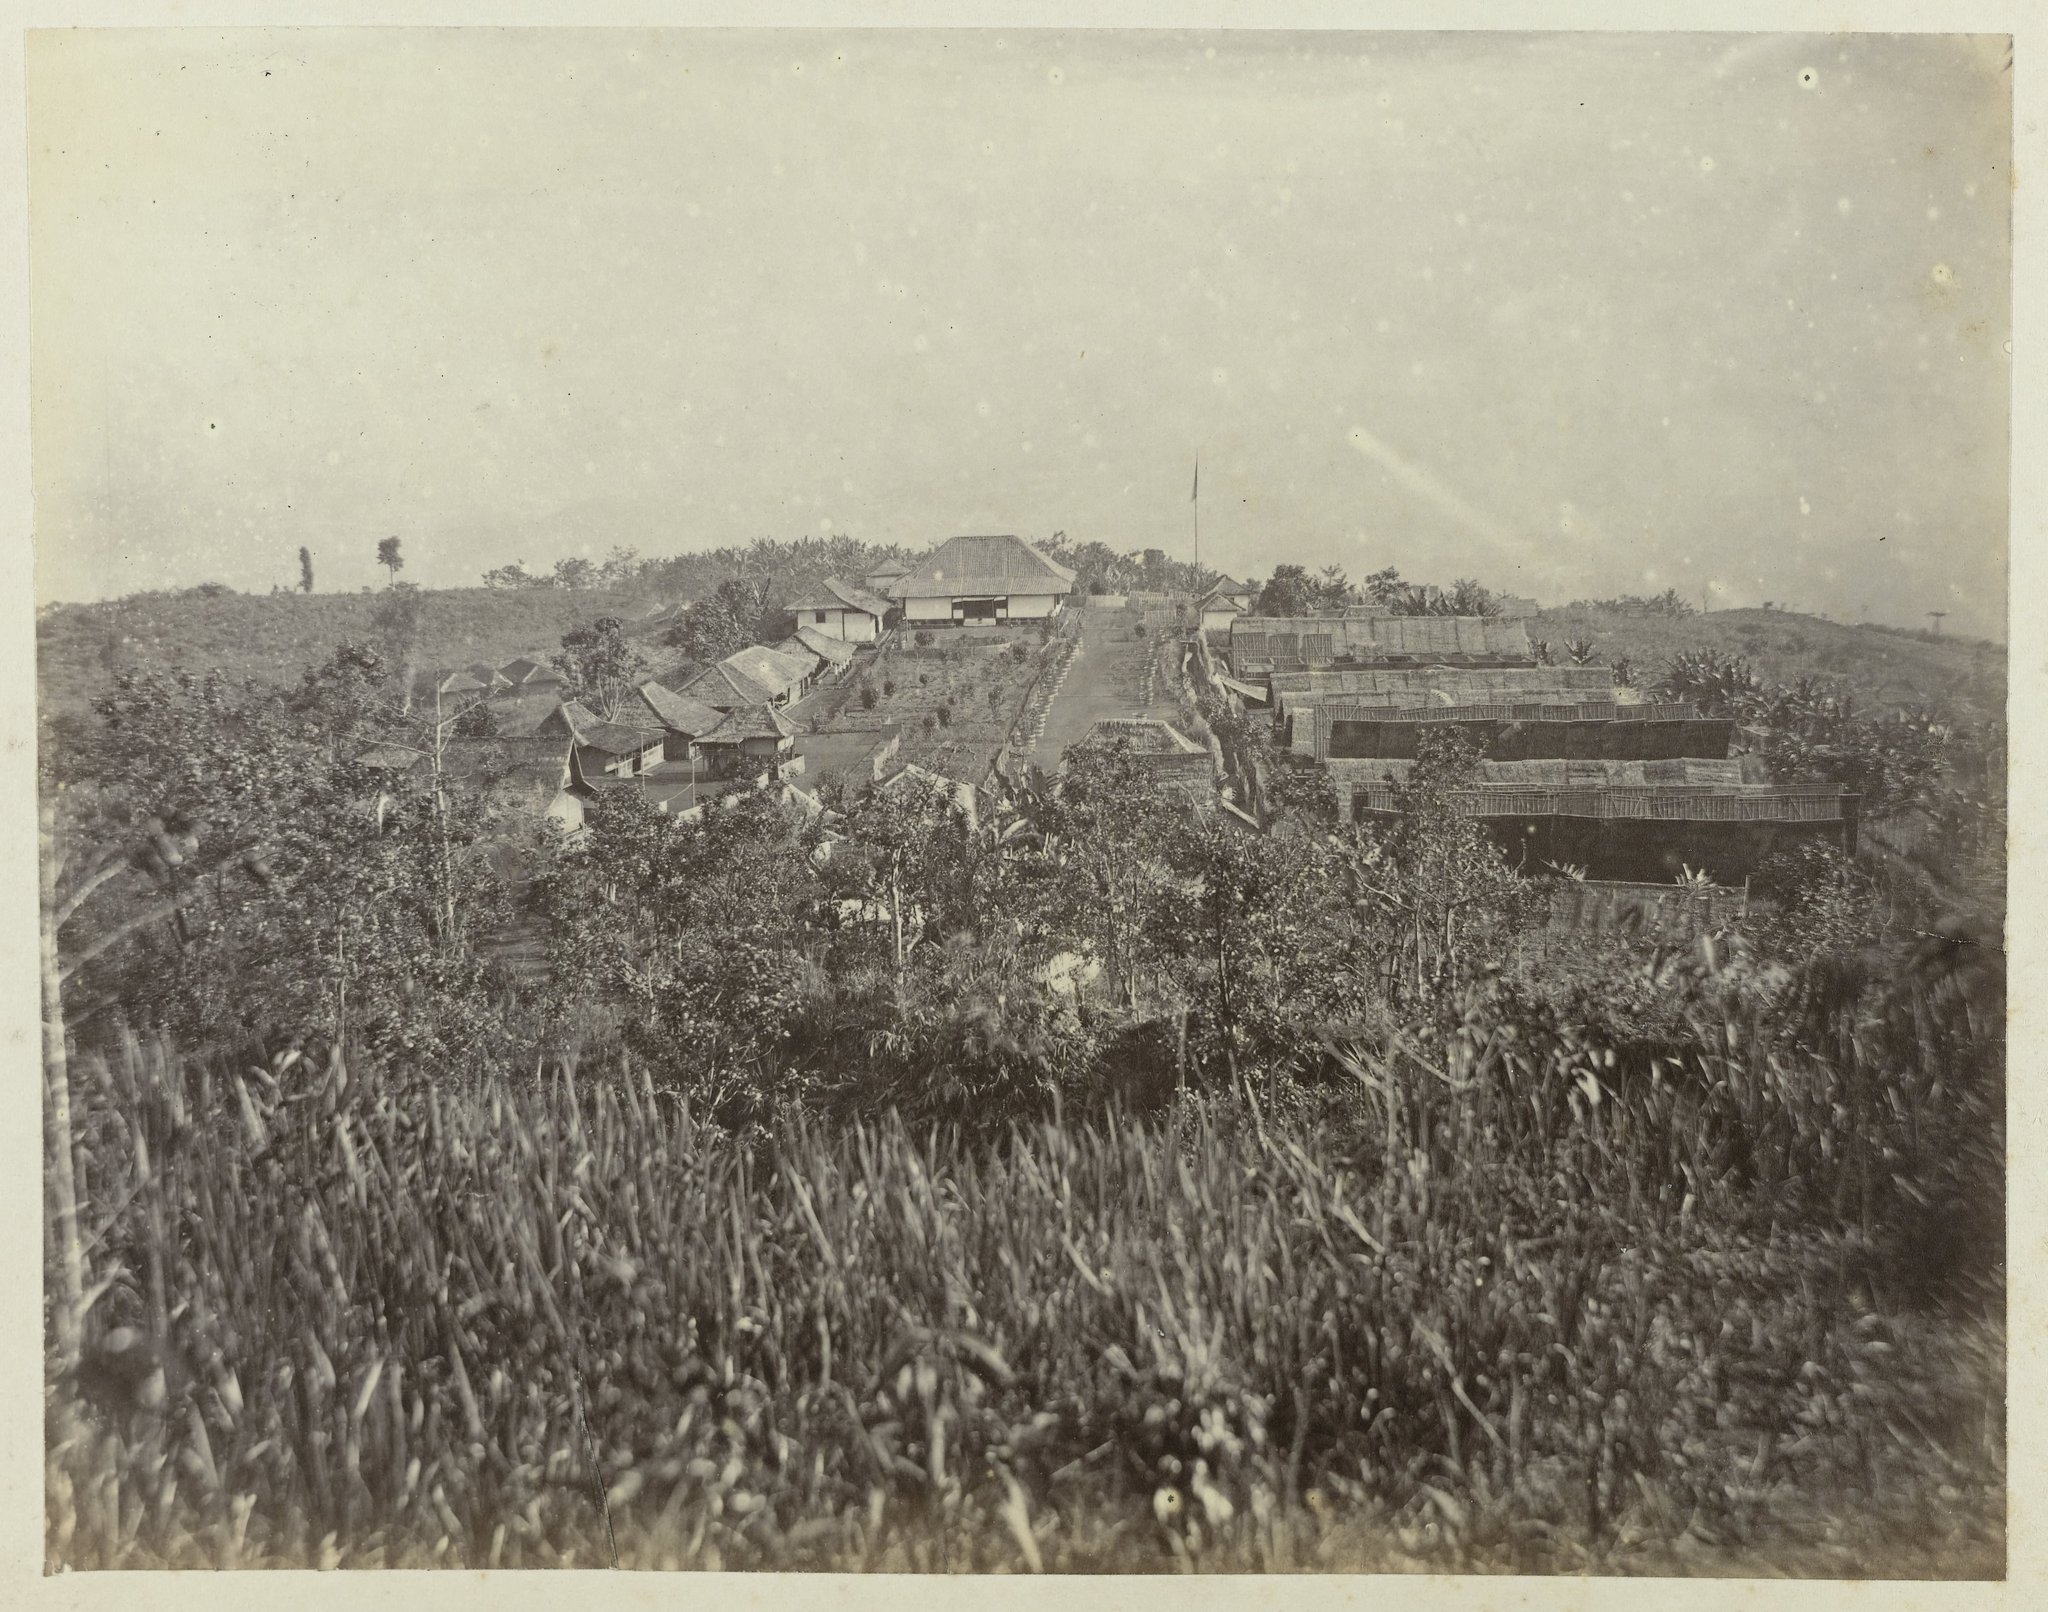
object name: photograph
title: Kamp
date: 1863-1869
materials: photographic support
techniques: albumen print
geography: java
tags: (military) camp with tents, java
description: Gezicht op een (militair) kamp, met een centraal pad met links huizen en rechts barakken. Onderdeel van het groene fotoalbum met foto's van Java, uit het bezit van apotheker Specht-Grijp, die in 1865 vanuit Batavia naar Nederland terugkeerde.